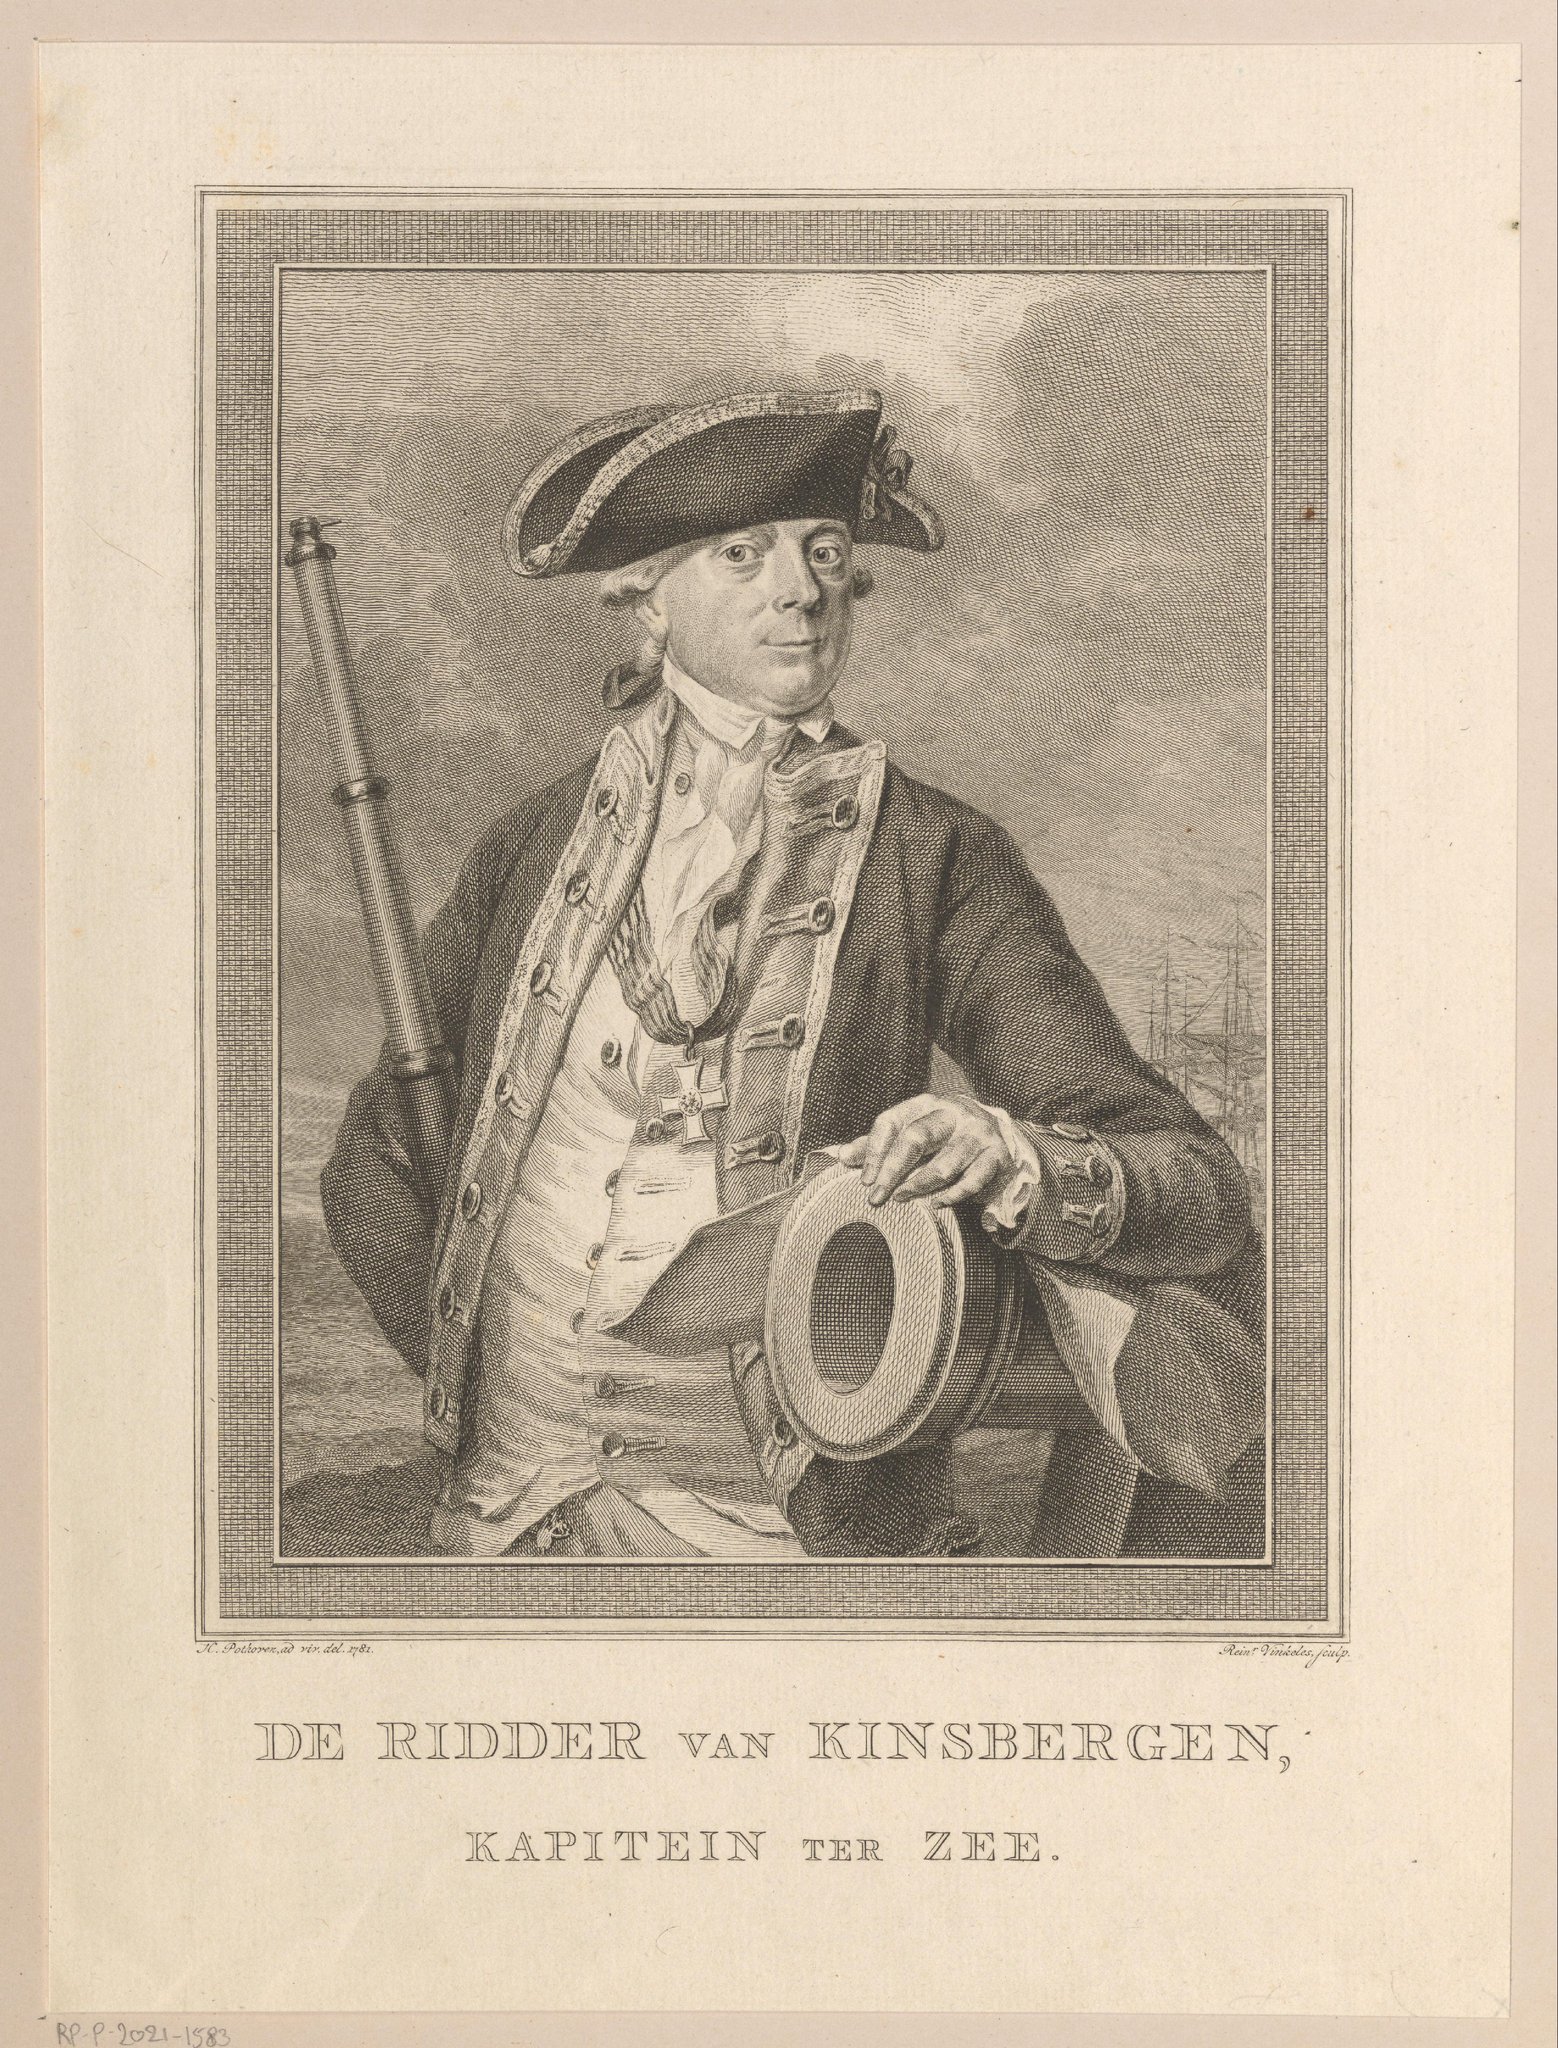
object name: print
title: Portret van jonkheer Jan Hendrik van Kinsbergen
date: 1781-1816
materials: paper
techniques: engraving, etching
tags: jonkheer jan hendrik van kinsbergen, historical persons, firearms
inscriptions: collector's mark: Lugt 240